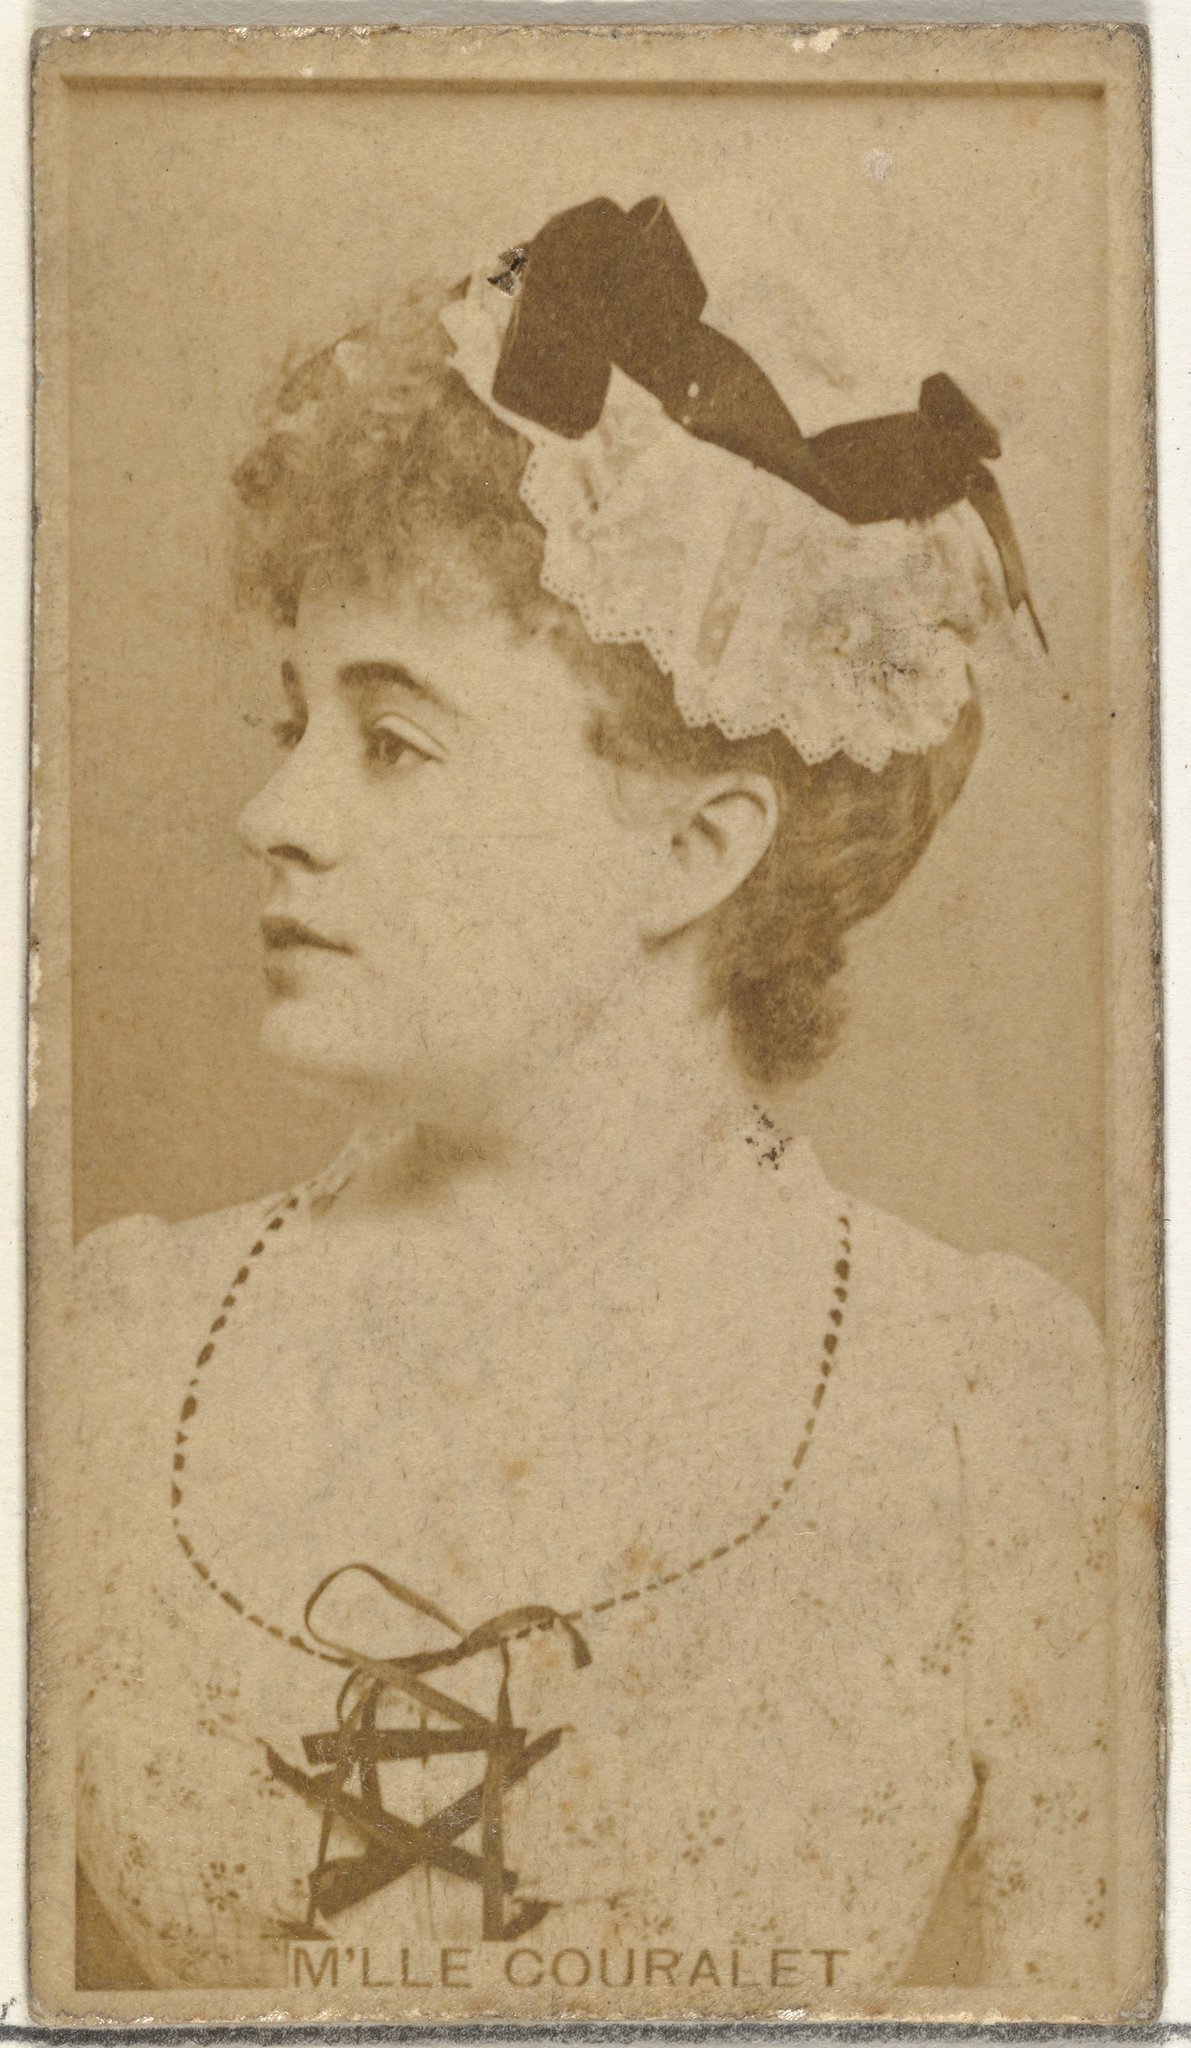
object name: photograph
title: M'lle Couralet, from the Actors and Actresses series (N145-8) issued by Duke Sons & Co. to promote Duke Cigarettes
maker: w. duke, sons & co.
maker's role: publisher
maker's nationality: american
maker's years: 1870-1920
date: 1891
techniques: albumen silver print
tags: portraits,women,actresses